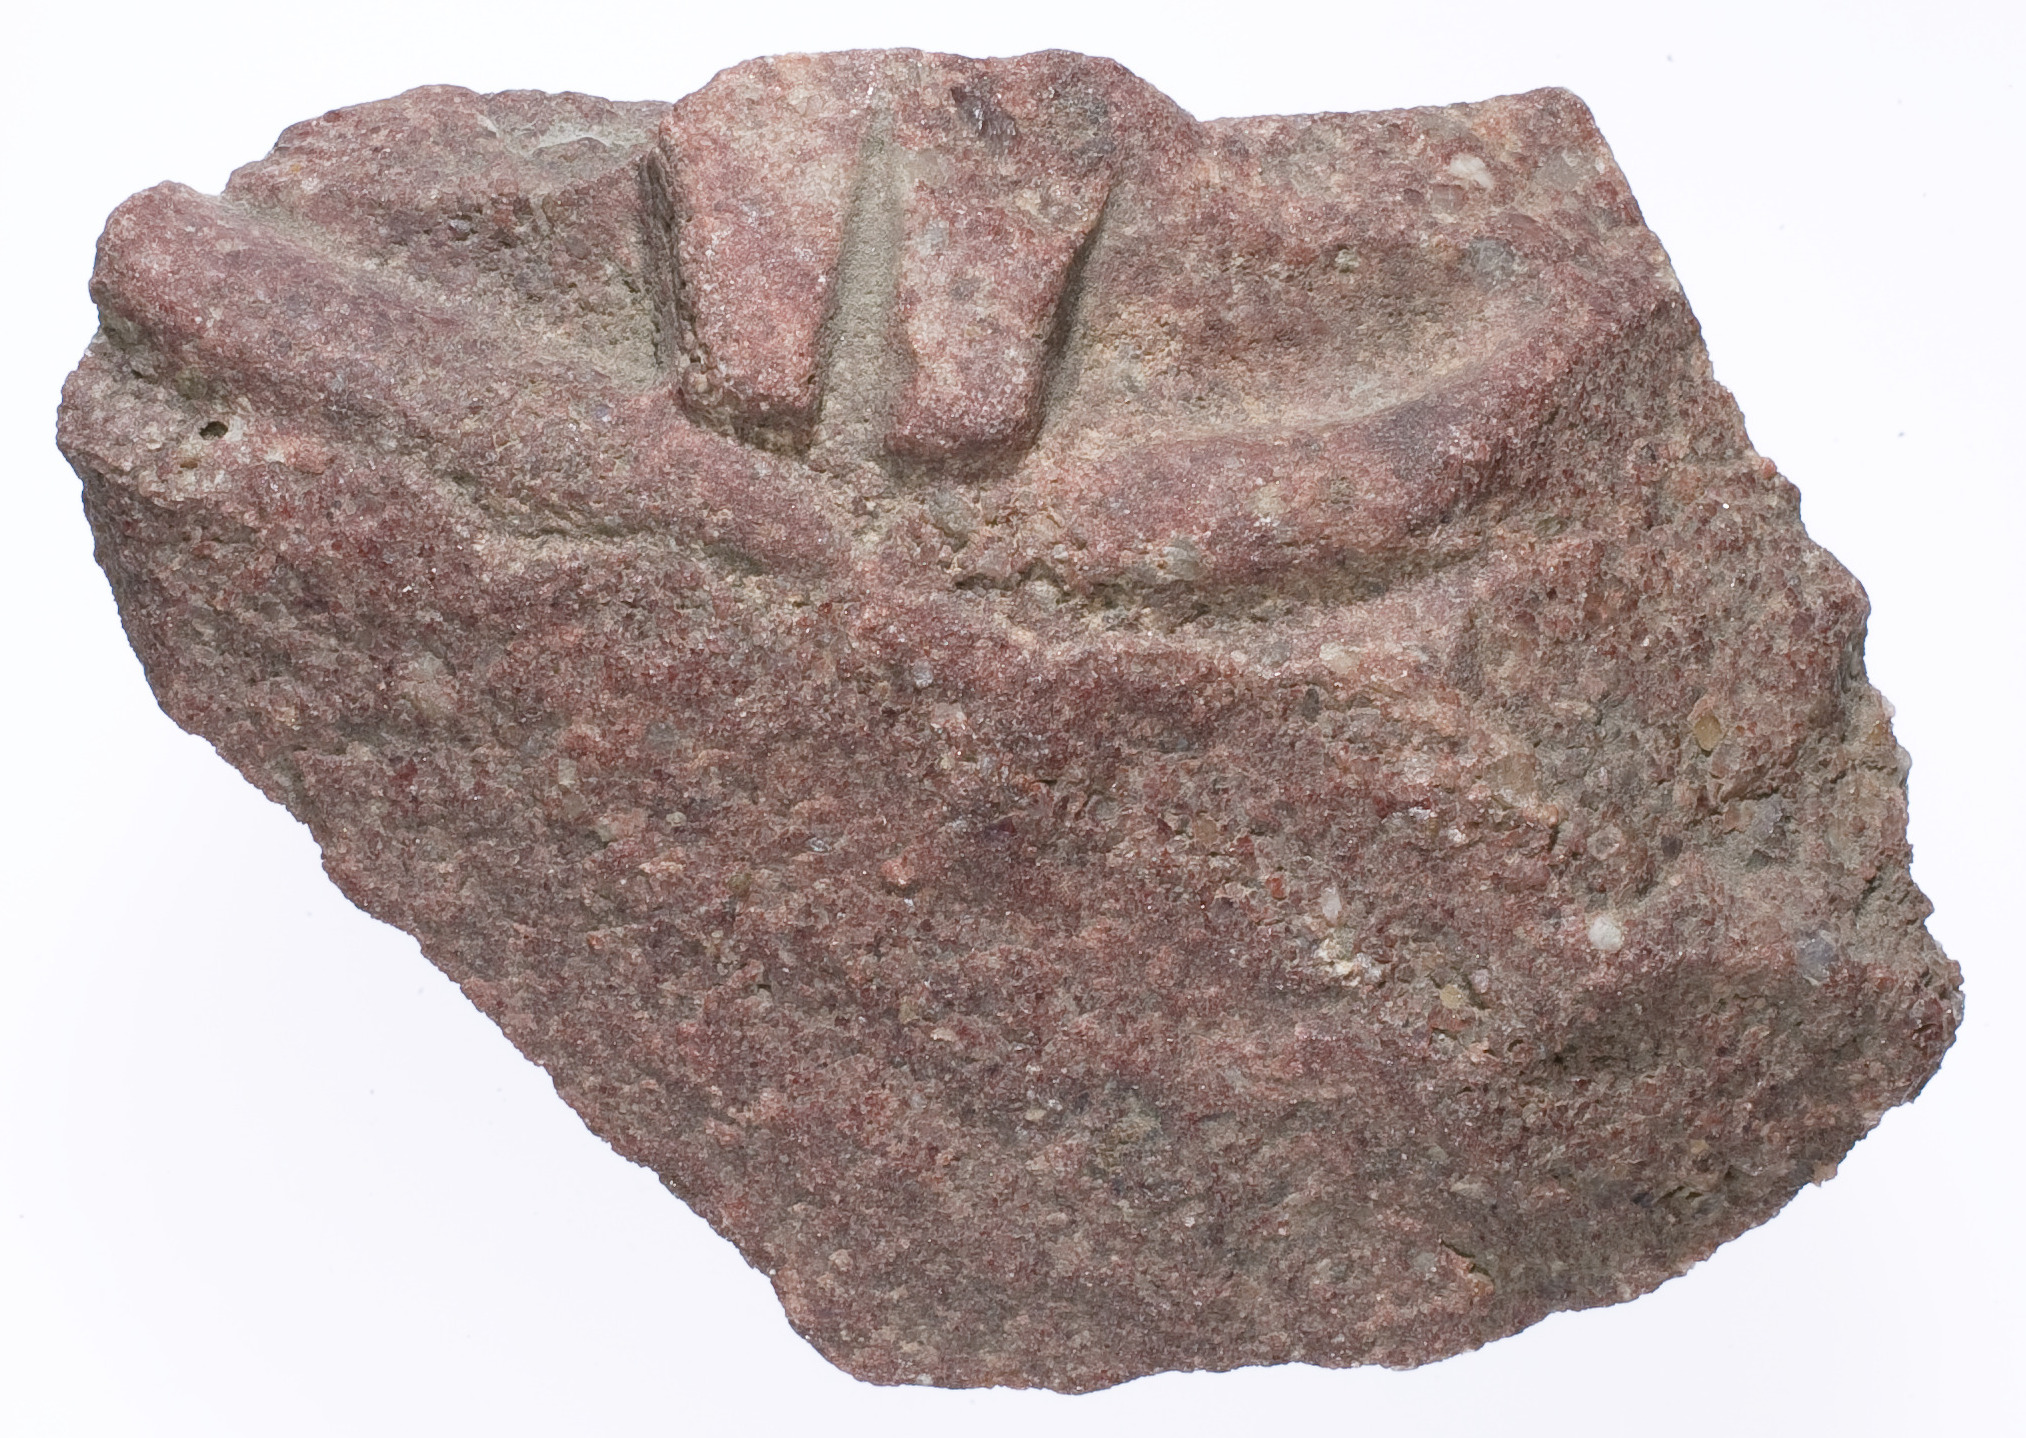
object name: double uraeus, disk and horn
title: Fragment of a queen's crown (?) with modius of uraeus, disk, horns and double uraeus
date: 1353-1336 BCE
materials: quartzite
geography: egypt